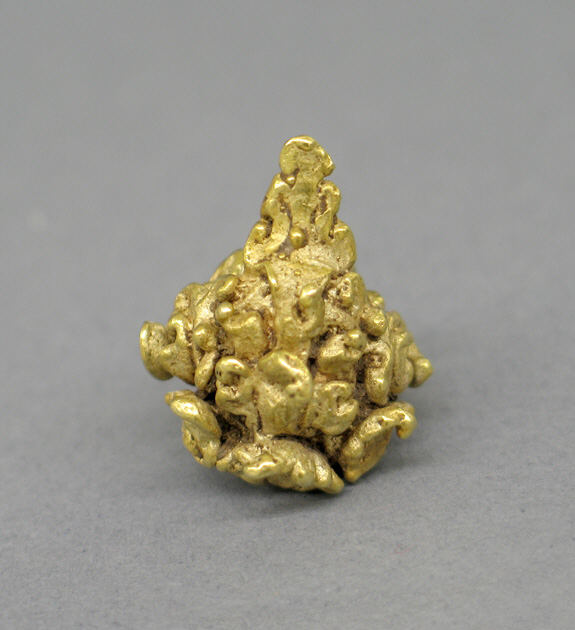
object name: finial clip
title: Rod Finial Clip with Foliate Designs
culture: indonesian, javanese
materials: gold